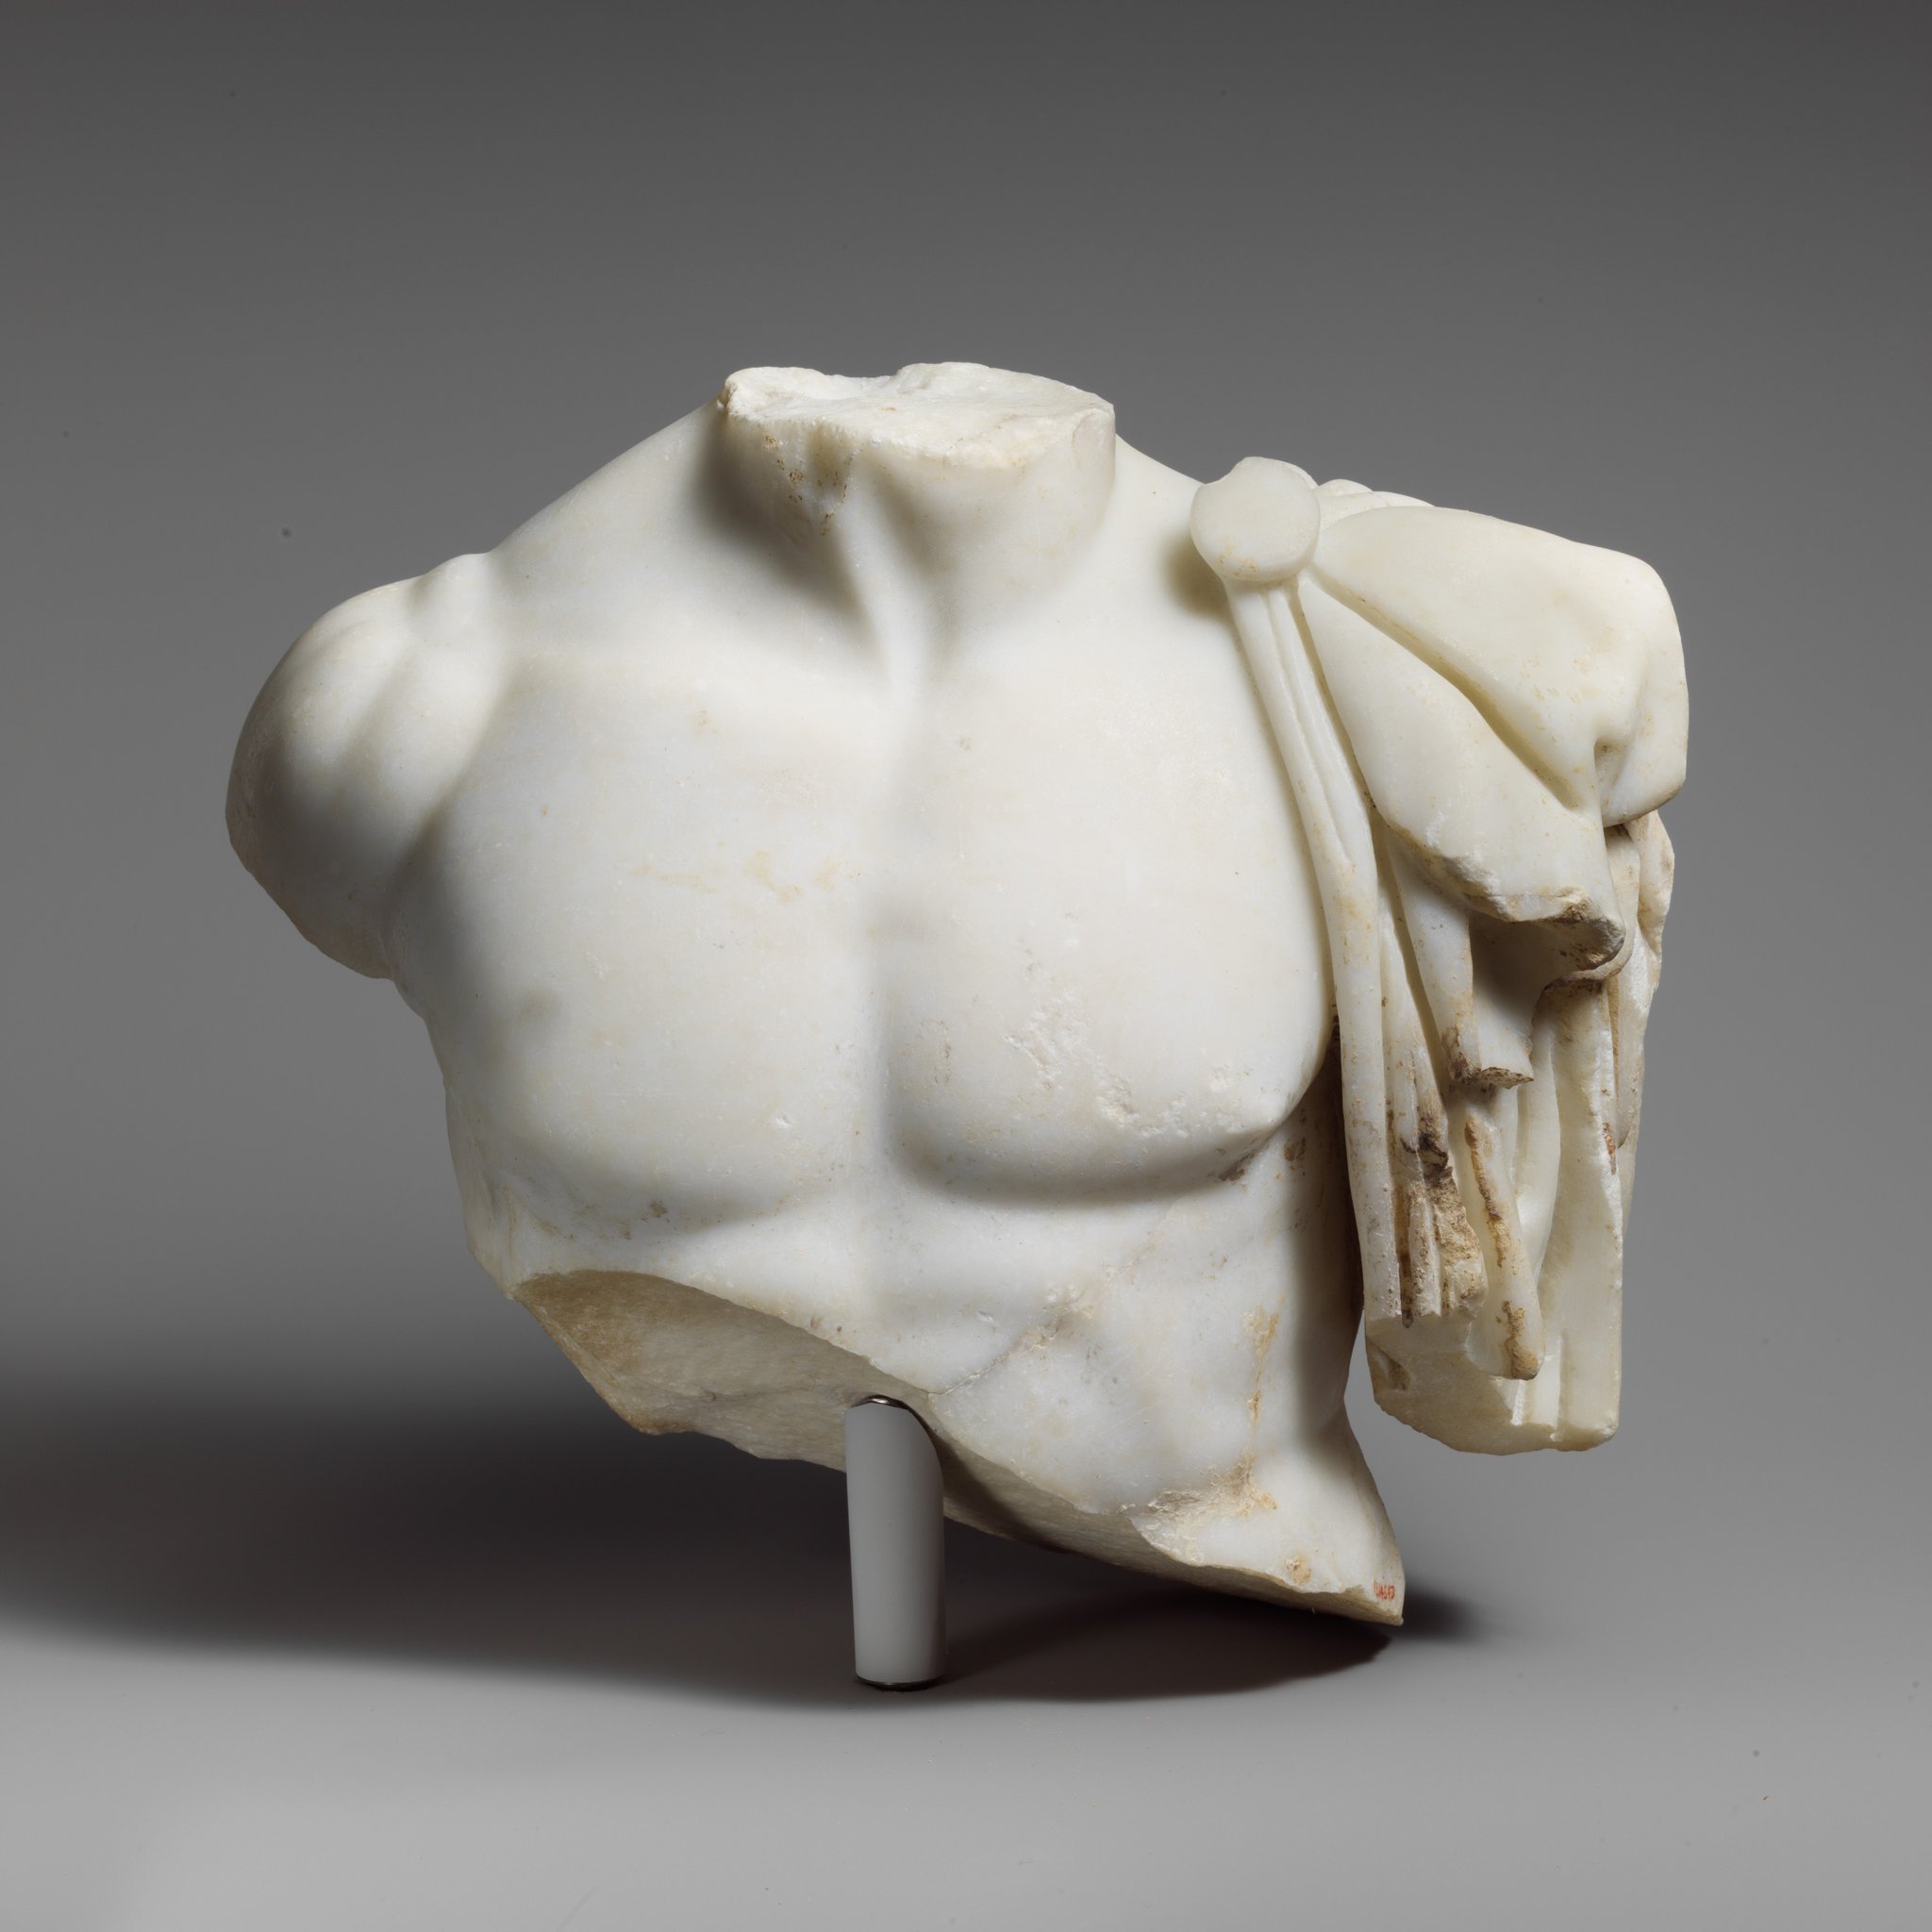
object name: torso of a youth, upper part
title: Upper part of a marble torso of a man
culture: roman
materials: marble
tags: men